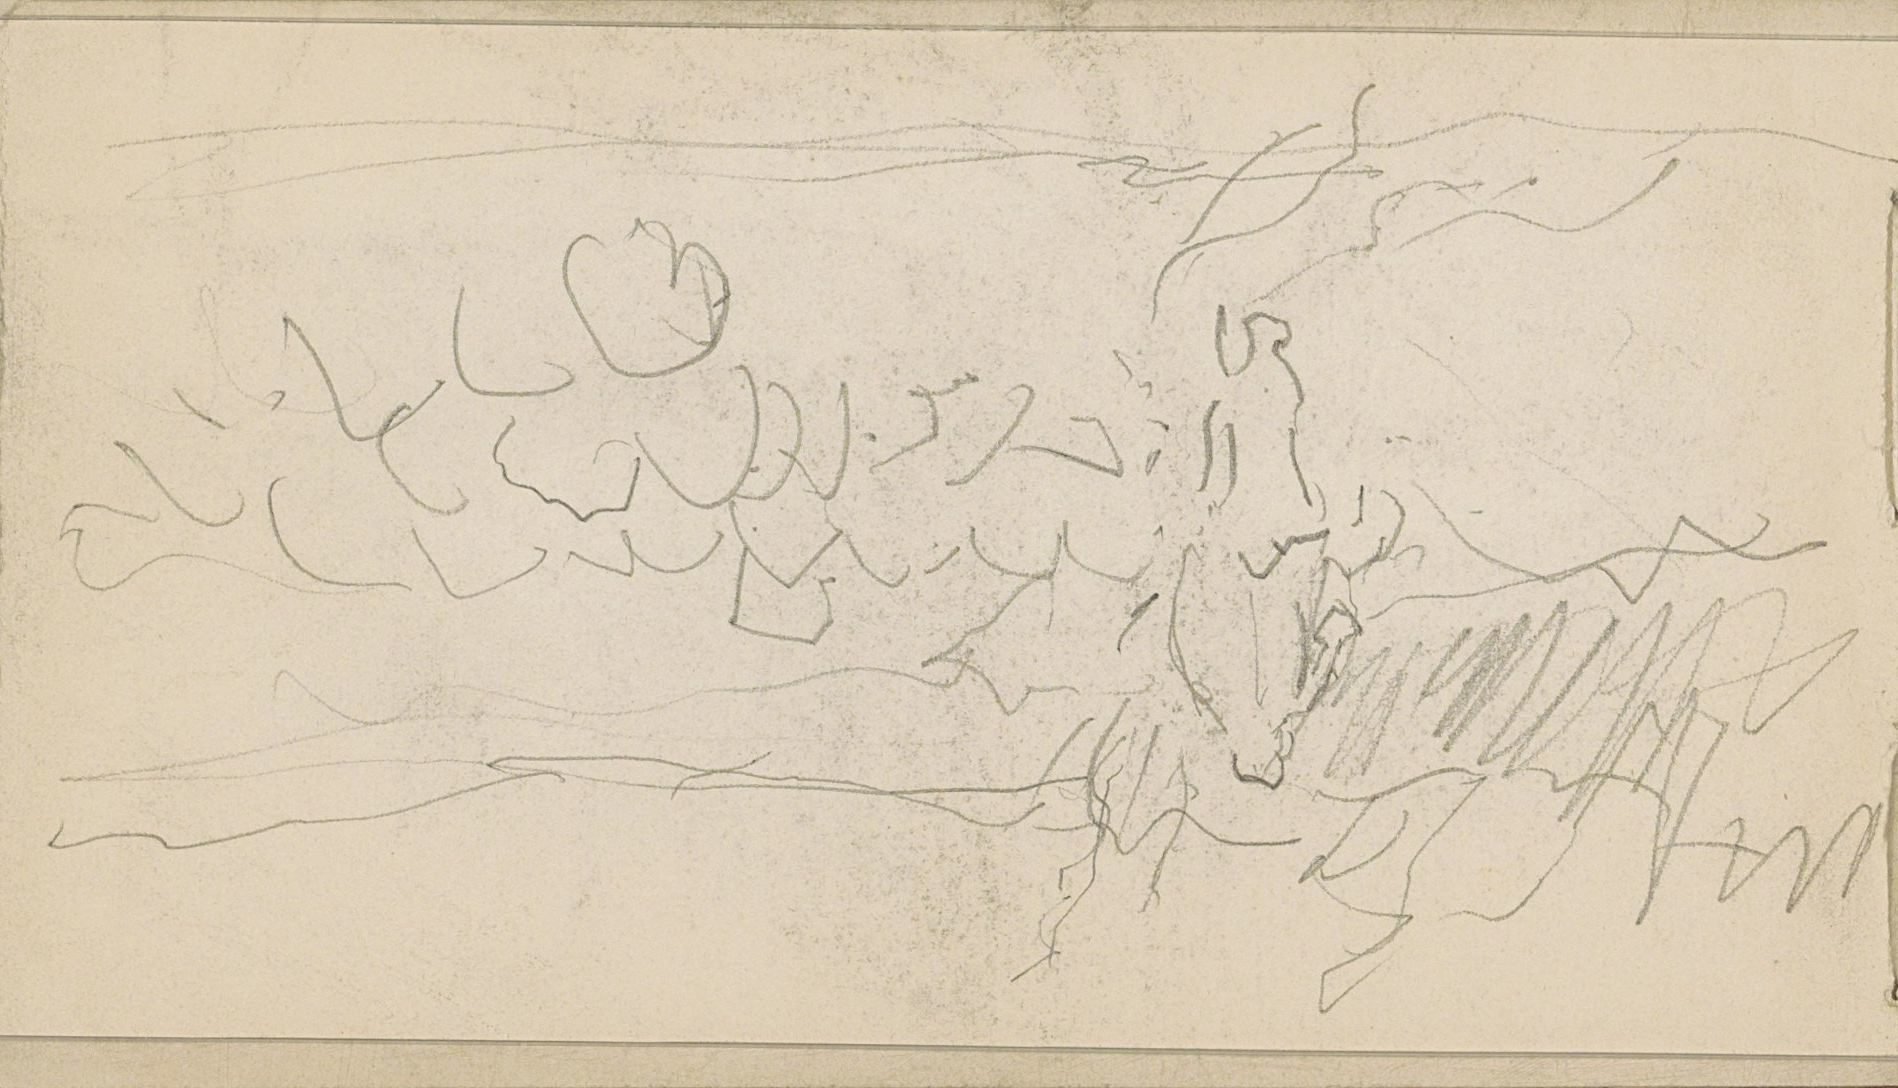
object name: sketchbook leaf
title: Herder met een kudde schapen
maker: anton mauve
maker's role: draughtsman, painter, print maker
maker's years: 1838-1888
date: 1876-1879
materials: paper, pencil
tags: herding, herdsman, herdswoman, shepherd, shepherdess, cowherd, etc., sheep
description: Blad 26 verso uit een schetsboek met 33 bladen.